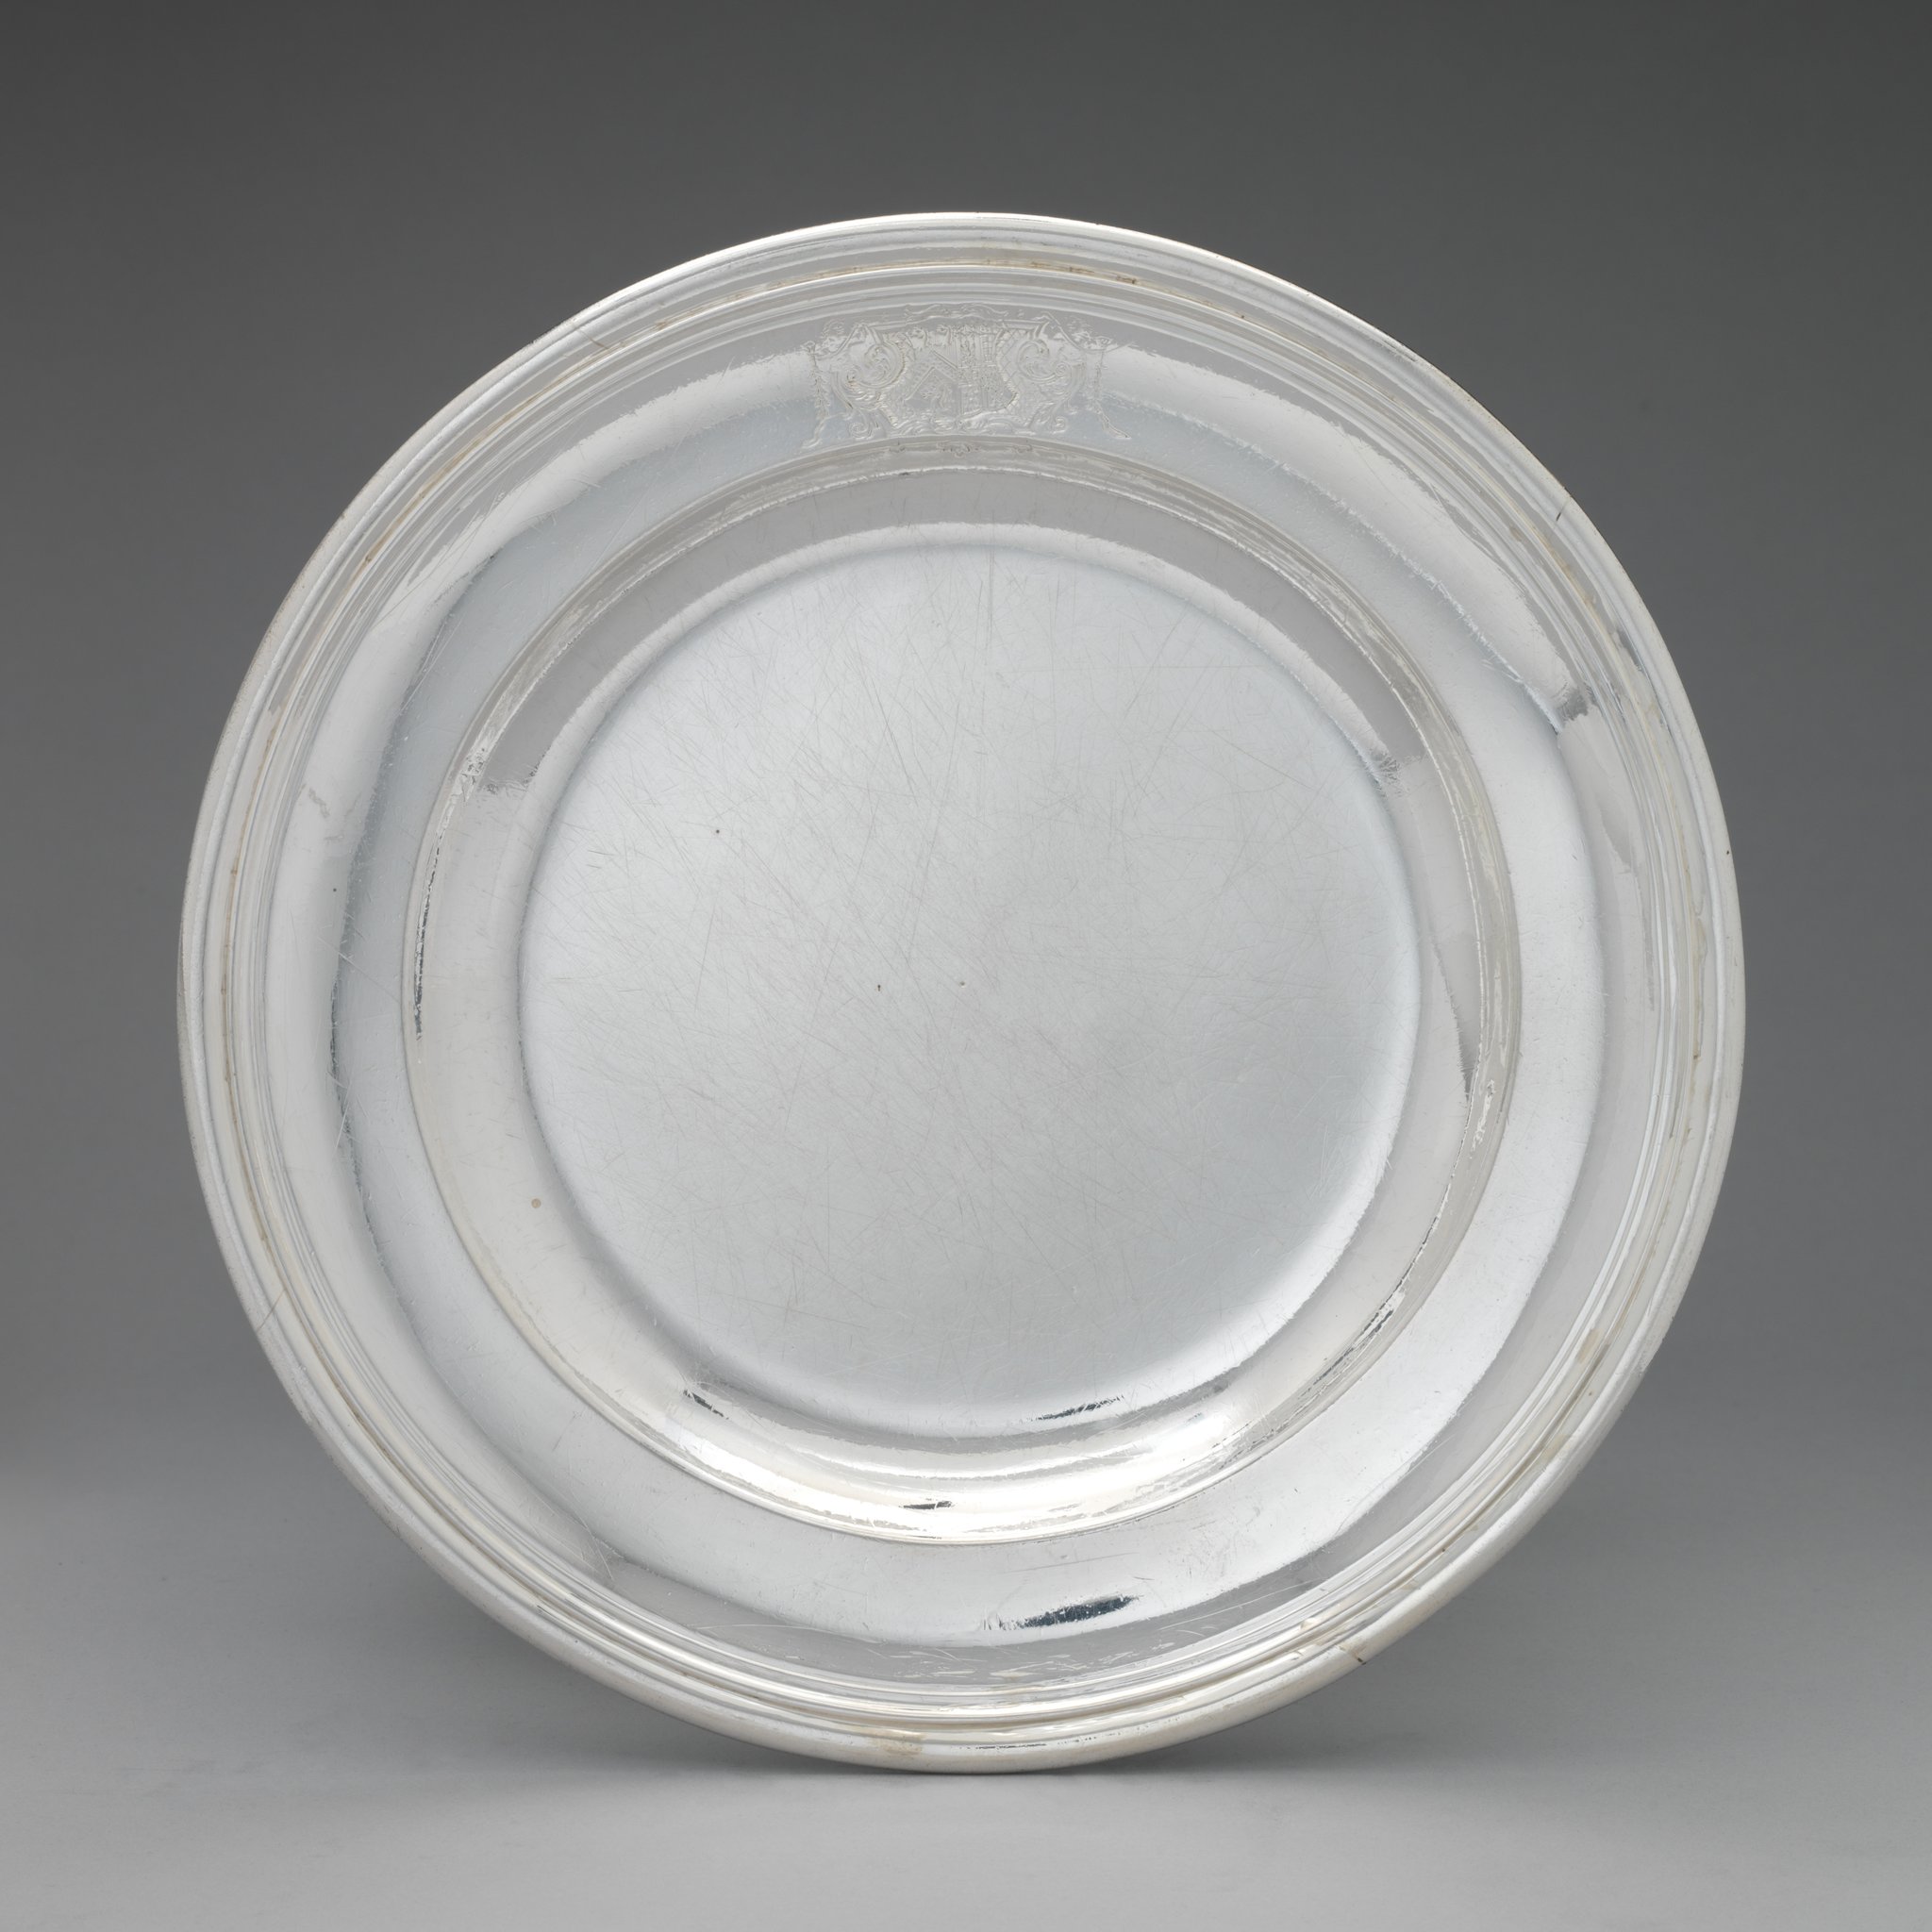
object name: plate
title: Plate (one of a set of twelve)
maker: thomas farren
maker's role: maker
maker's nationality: british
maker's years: 1703-1743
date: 1715-1716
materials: silver